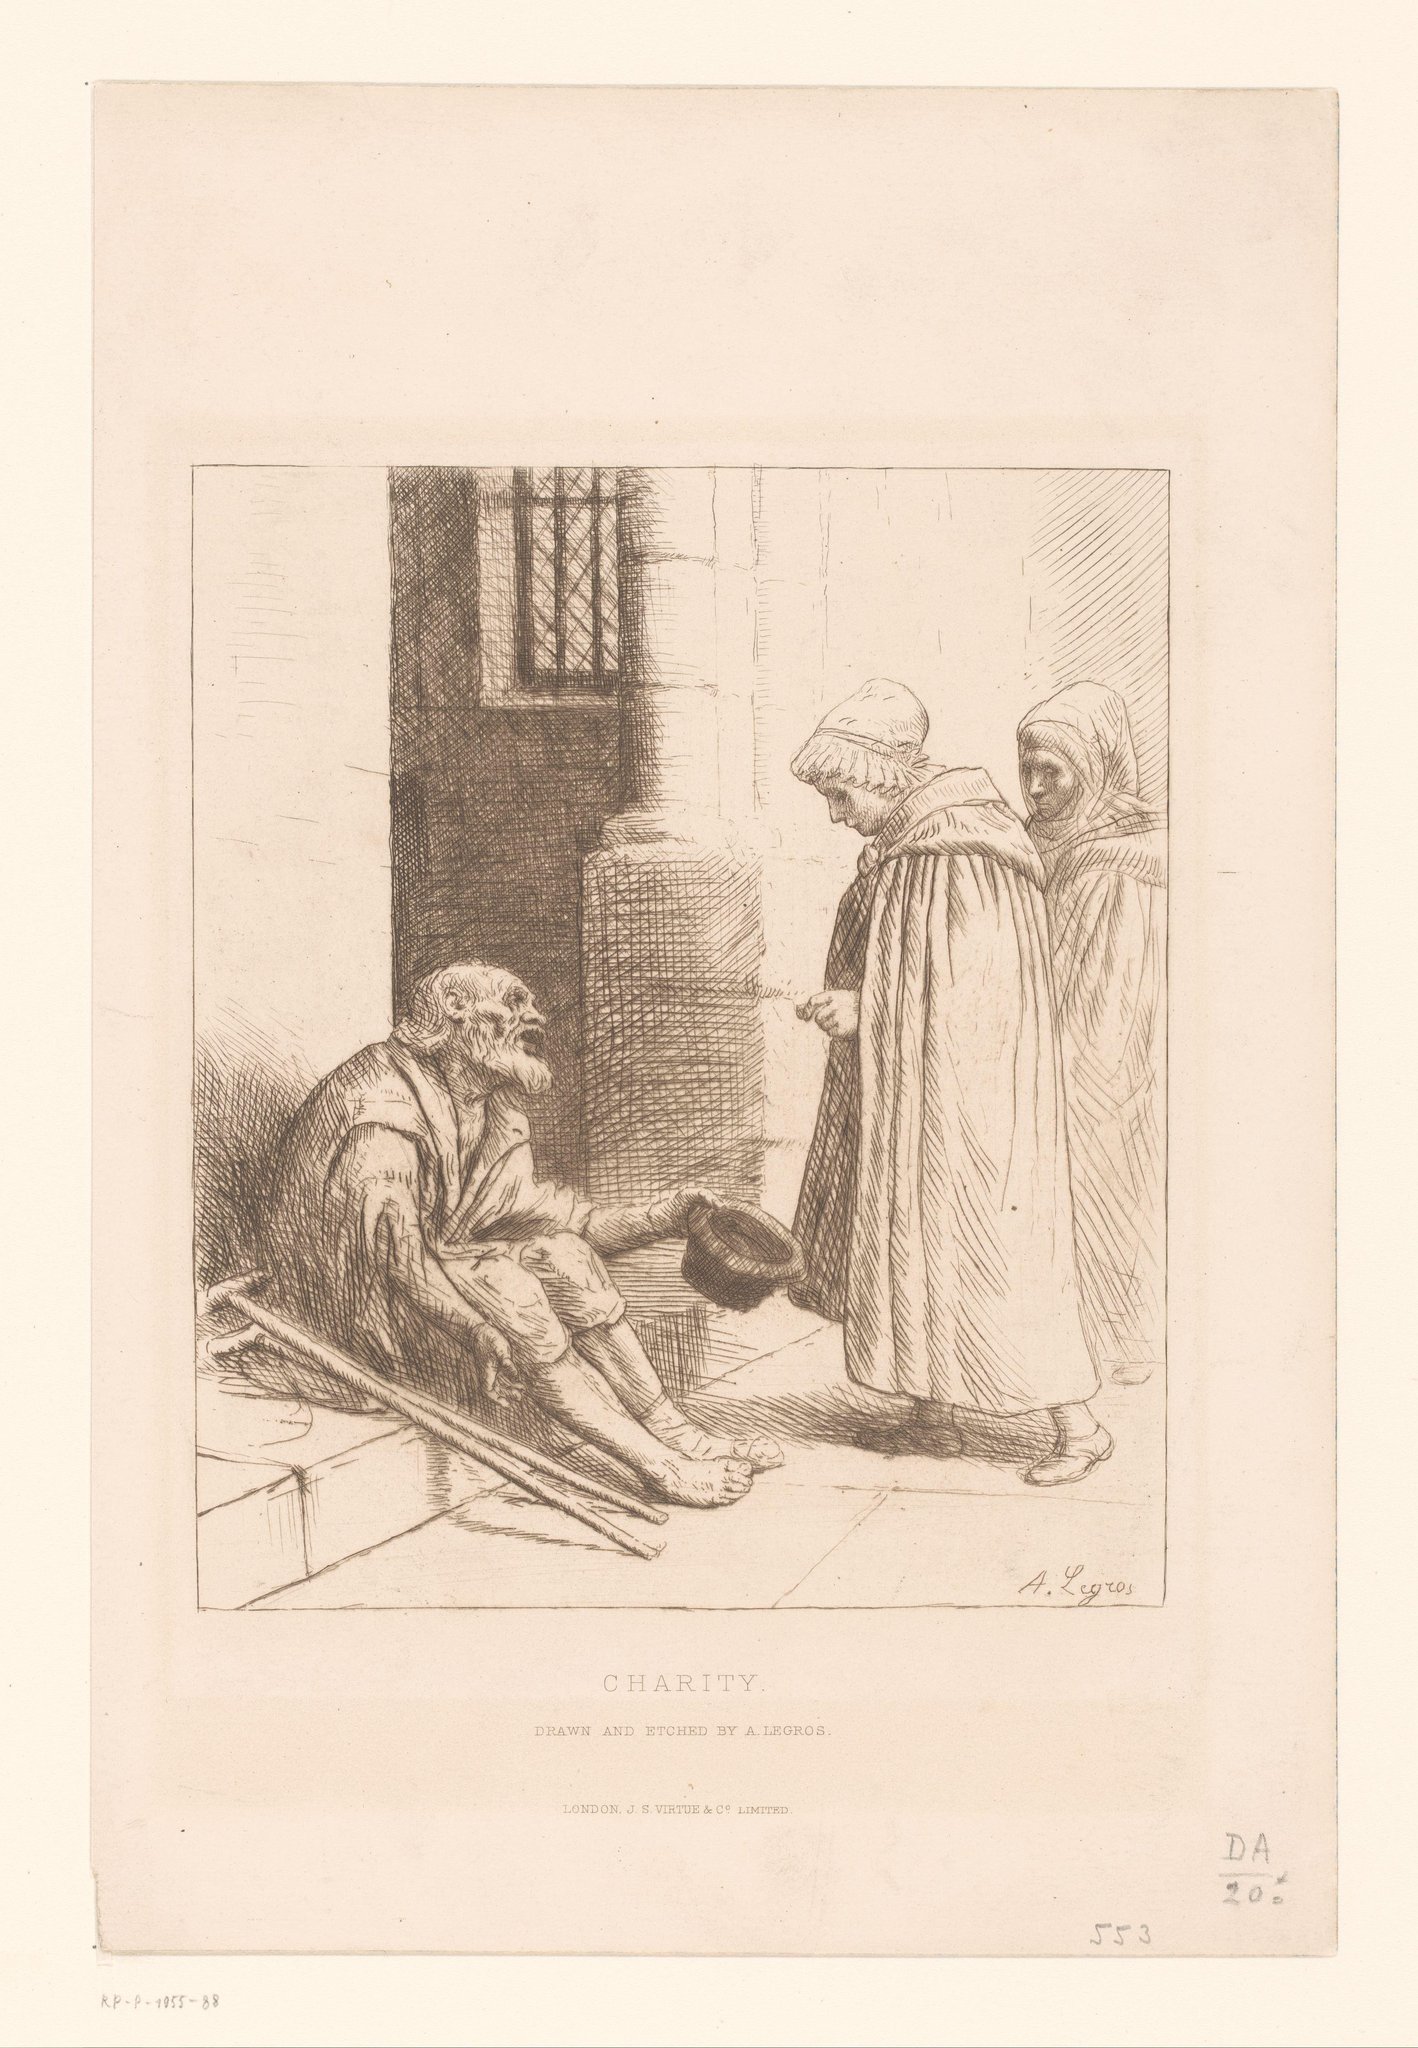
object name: print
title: Bedelaar op een trap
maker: alphonse legros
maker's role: print maker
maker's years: 1837-1911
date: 1837-1911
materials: paper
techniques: drypoint, engraving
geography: london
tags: charity, 'caritas'; 'carità' (ripa) ~ one of the three theological virtues, front steps, beggar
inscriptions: collector's mark: Lugt 2228